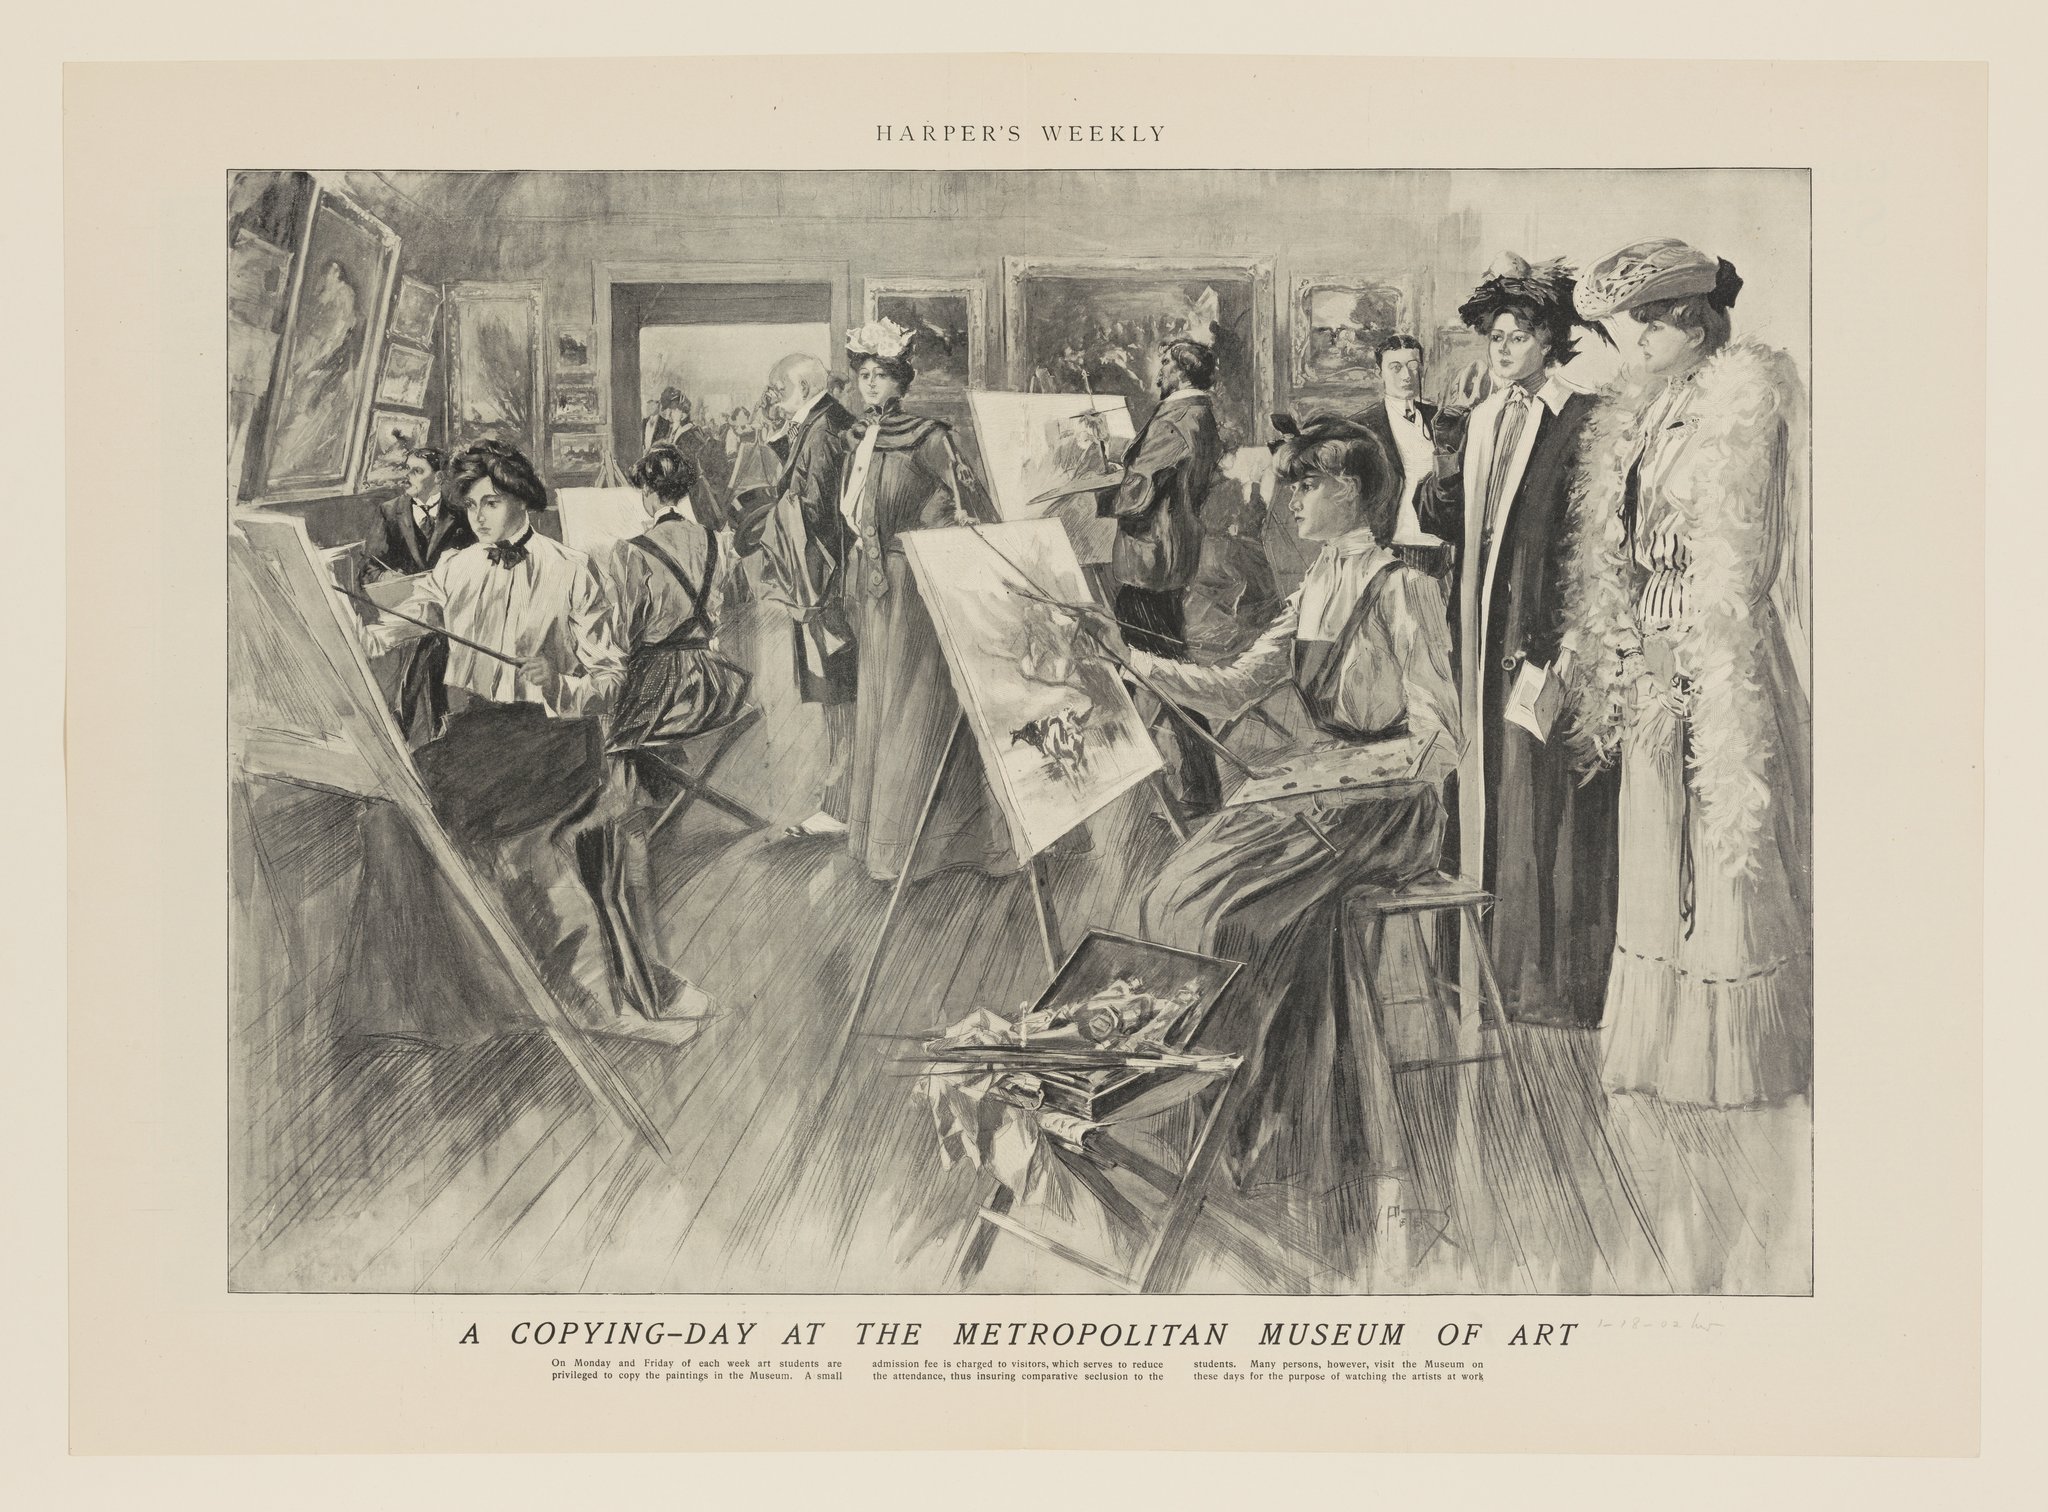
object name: print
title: A Copying-Day at the Metropolitan Museum of Art, from "Harper's Weekly"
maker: w. c. peters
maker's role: artist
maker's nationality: american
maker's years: 1800-1900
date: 1902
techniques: drawing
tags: painting,museums,easels